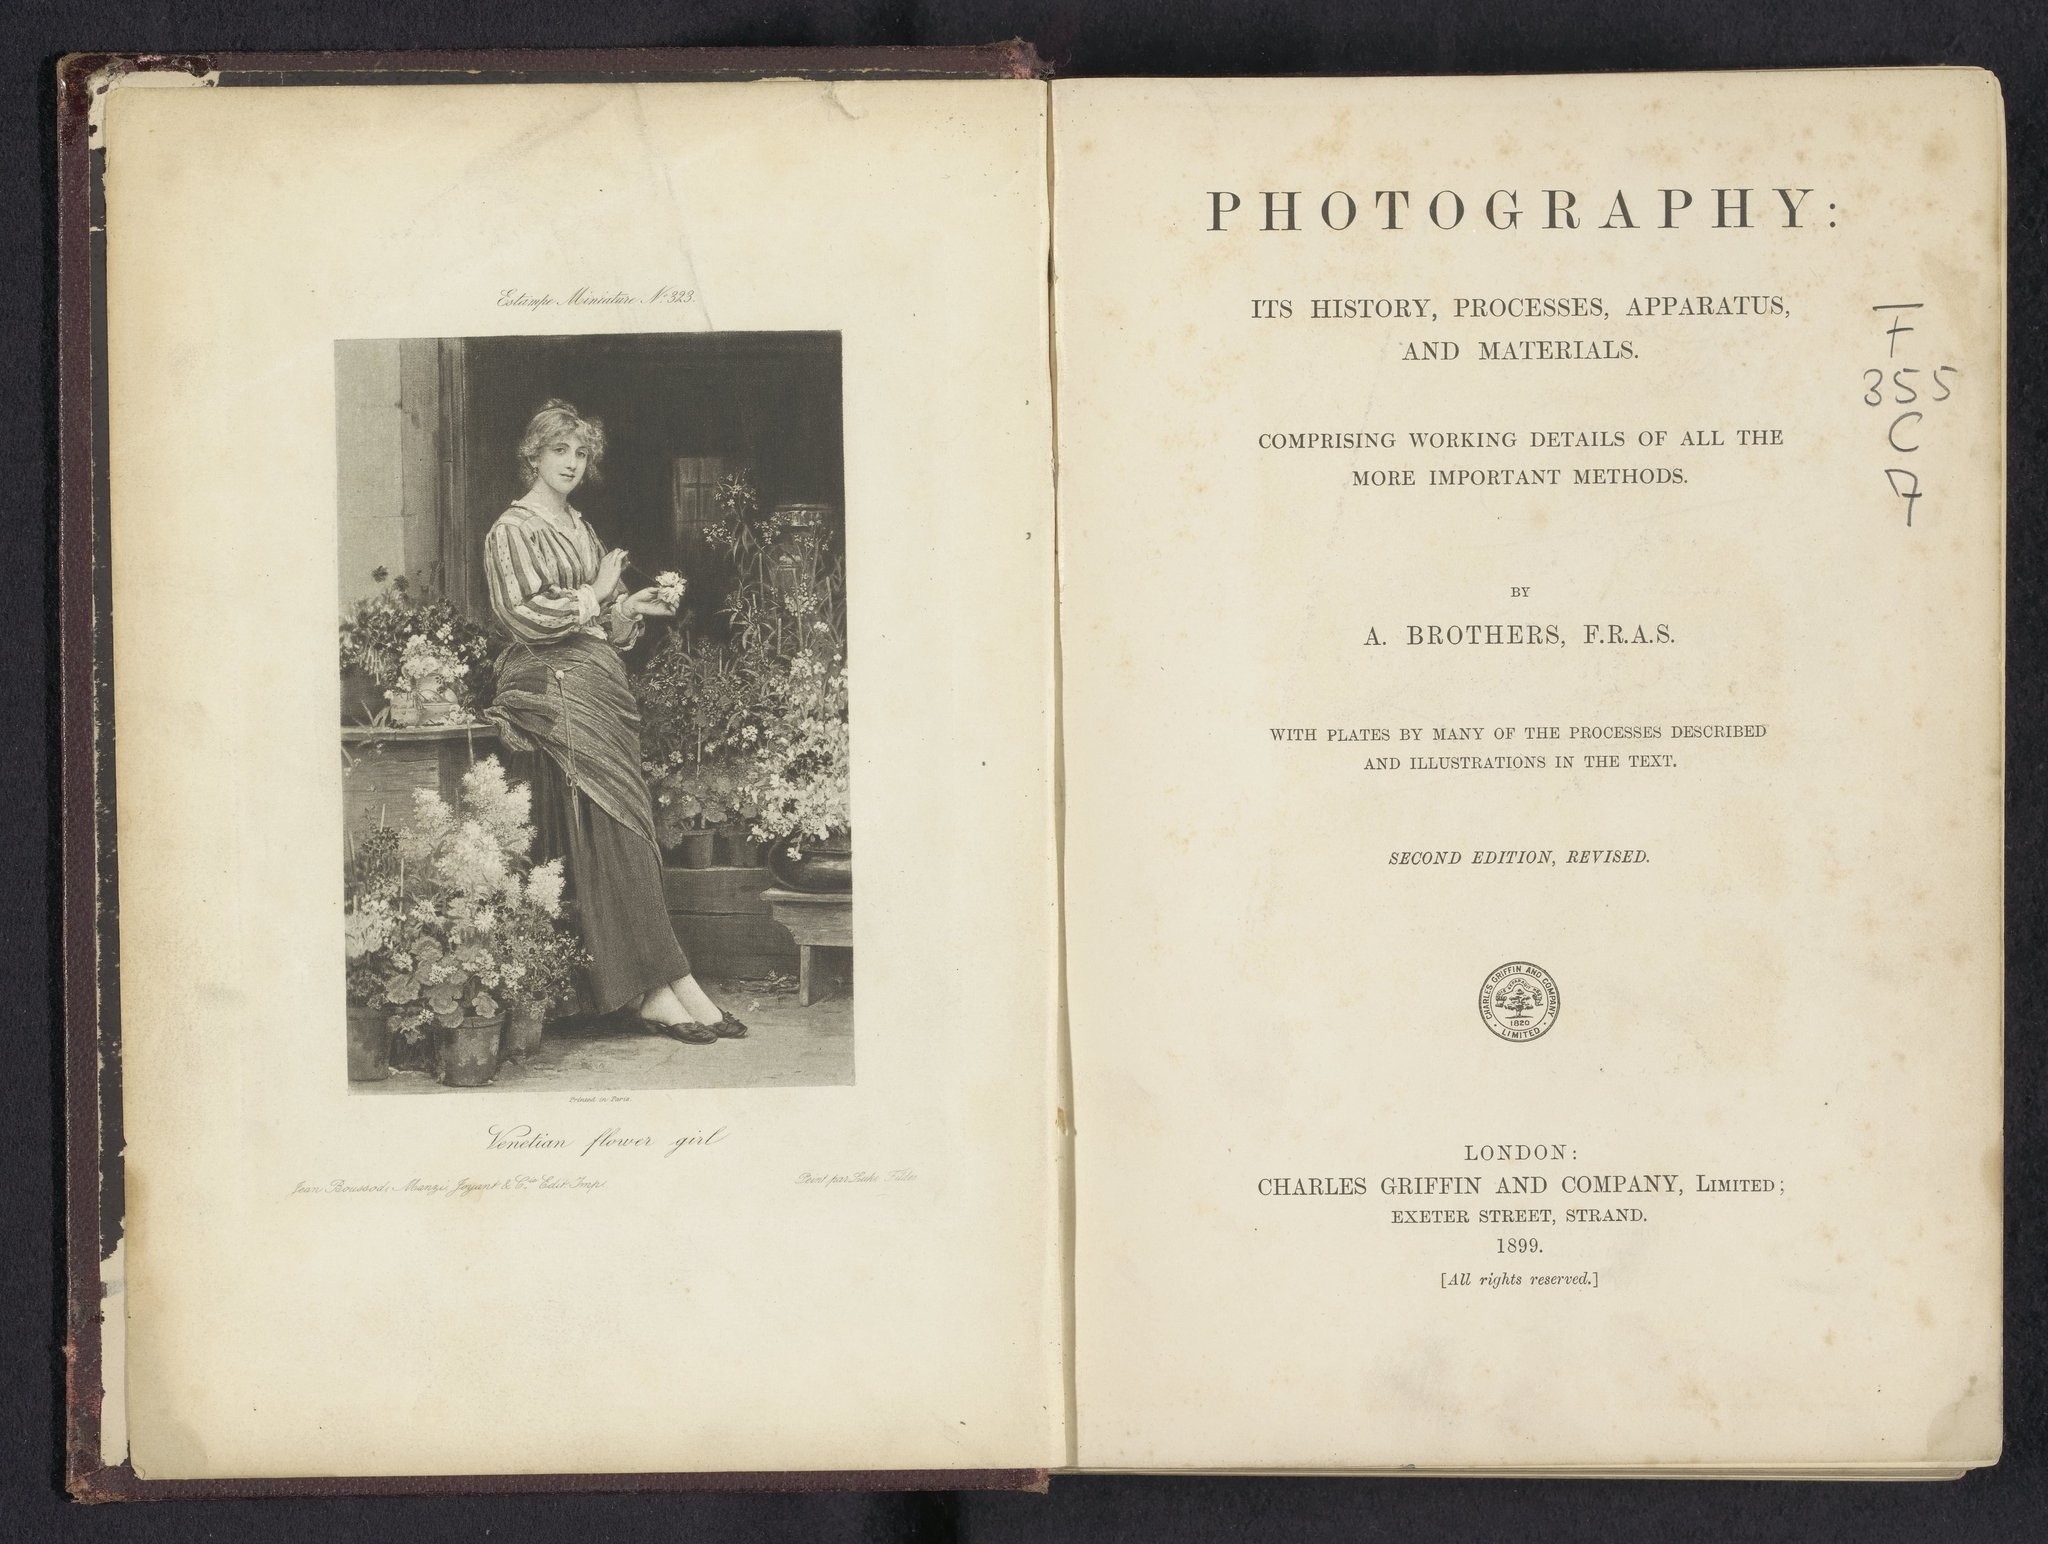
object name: reproduction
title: Venetian flower girl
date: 1889-1899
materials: paper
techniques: photoaquatint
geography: paris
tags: cut flowers; nosegay, bunch of flowers, stall, booth (~ market)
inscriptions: inscription: ‘Estampe Miniature No. 323.’